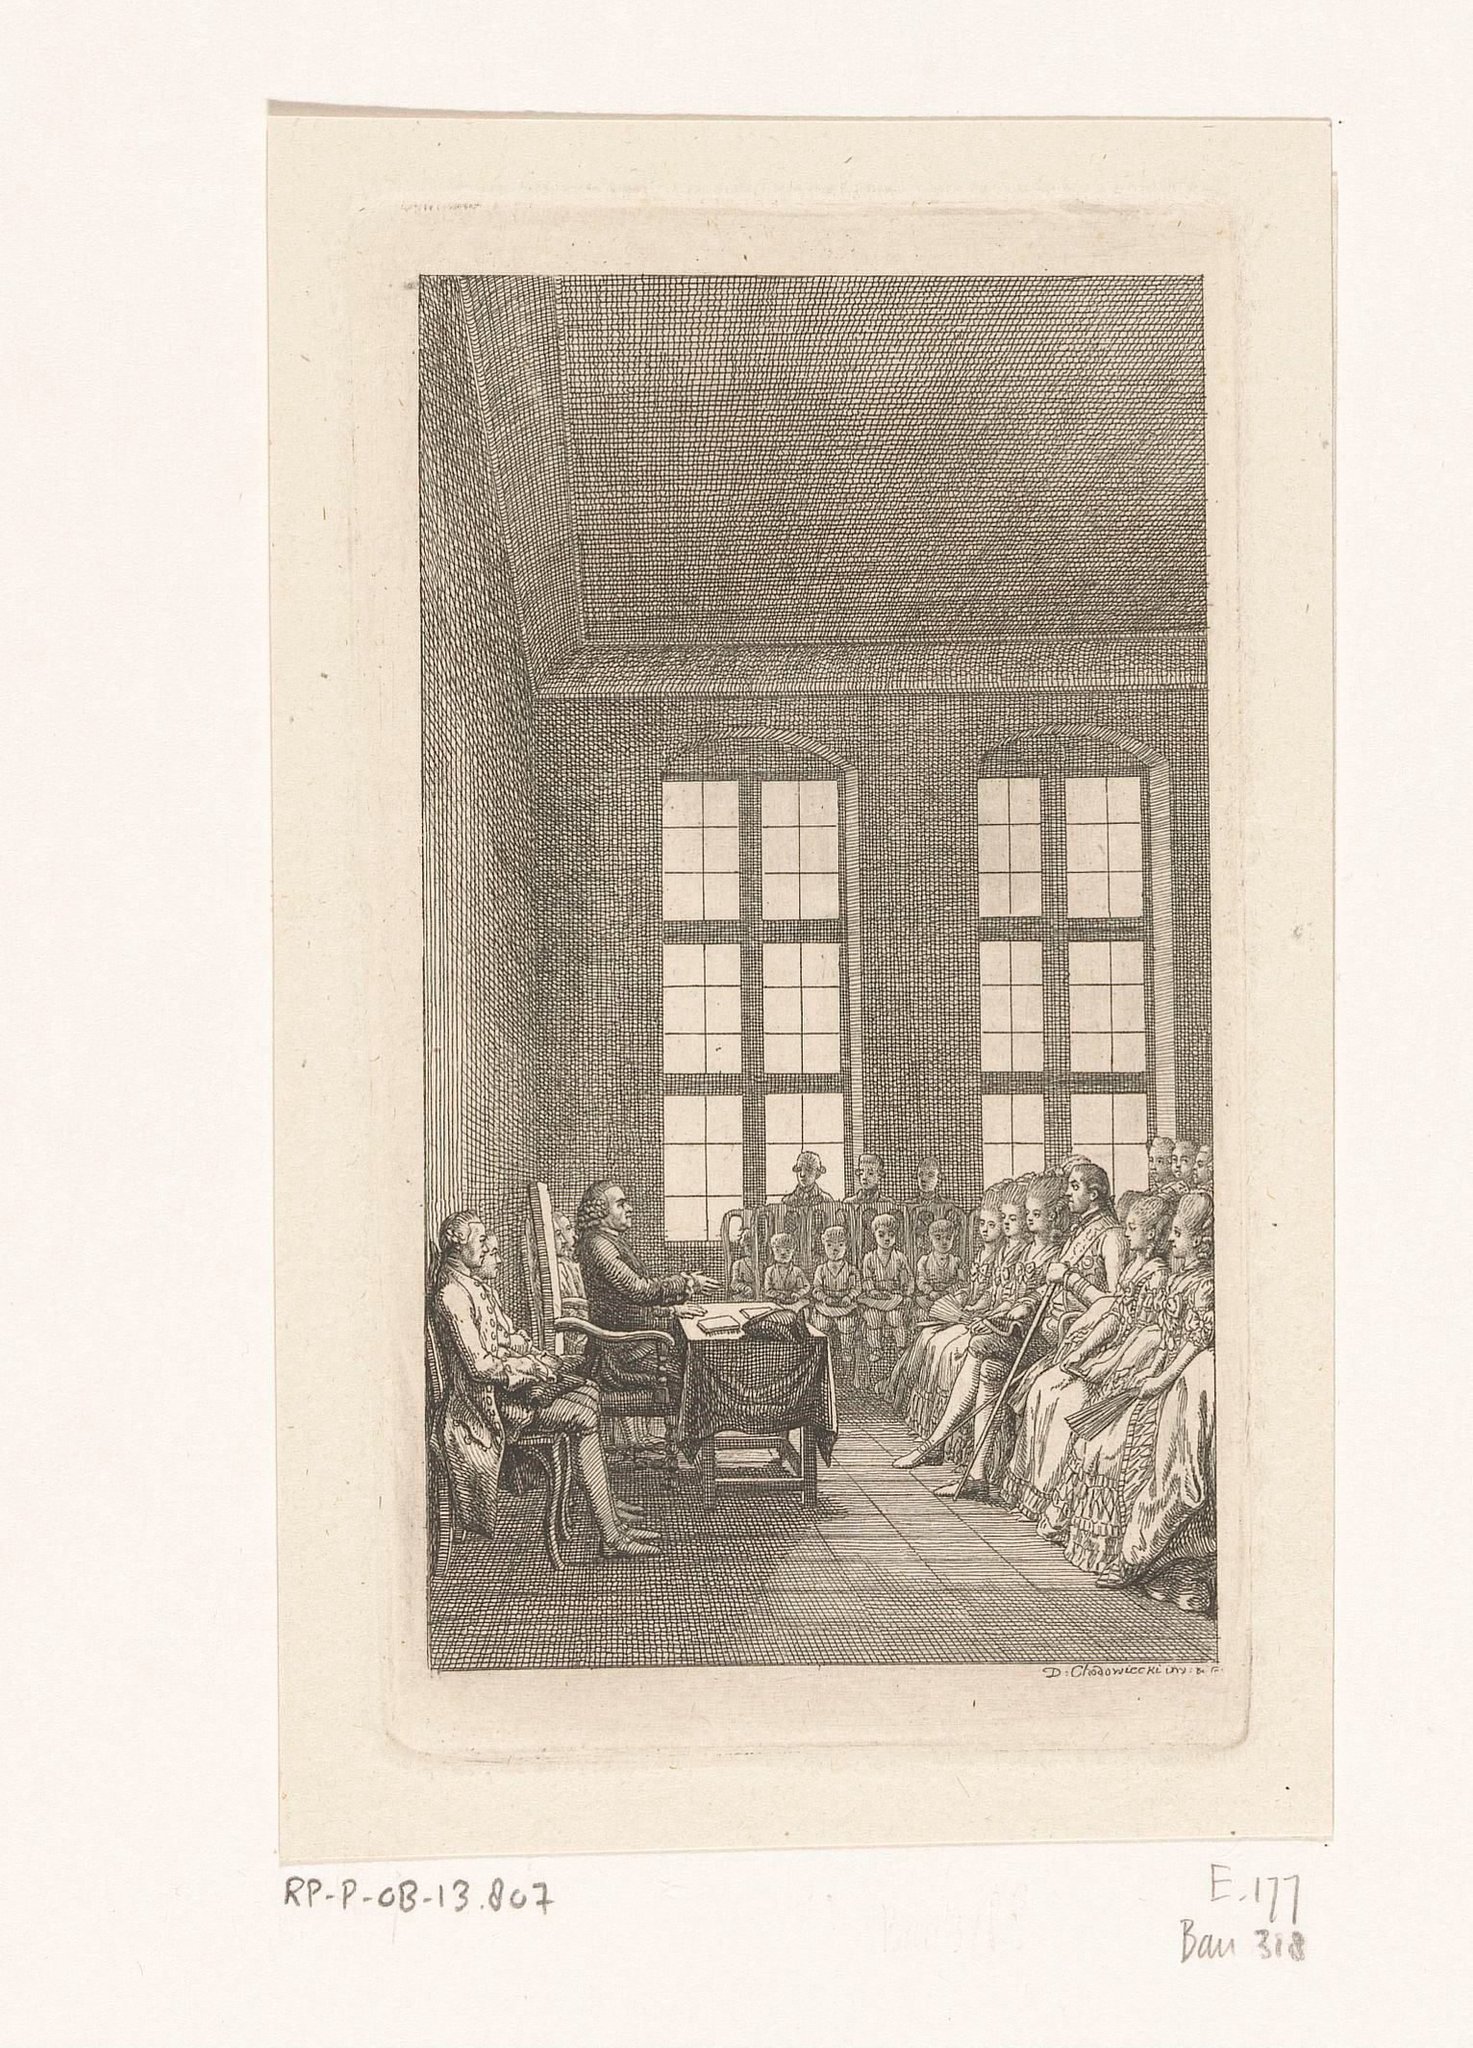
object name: print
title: Johann Bernhard Basedow houdt een lezing in het Philanthropinum te Dessau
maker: daniel nikolaus chodowiecki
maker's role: draughtsman, print maker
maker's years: 1726-1801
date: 1776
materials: paper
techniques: etching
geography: berlin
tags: johann bernhard basedow, address, talk, lecture (~ meeting), scholastic education, tuition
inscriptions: collector's mark: Lugt 2228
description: Tegenover Basedow zit de vorstelijke familie van Dessau. Voor de ramen zitten en staan de leerlingen van het internaat.